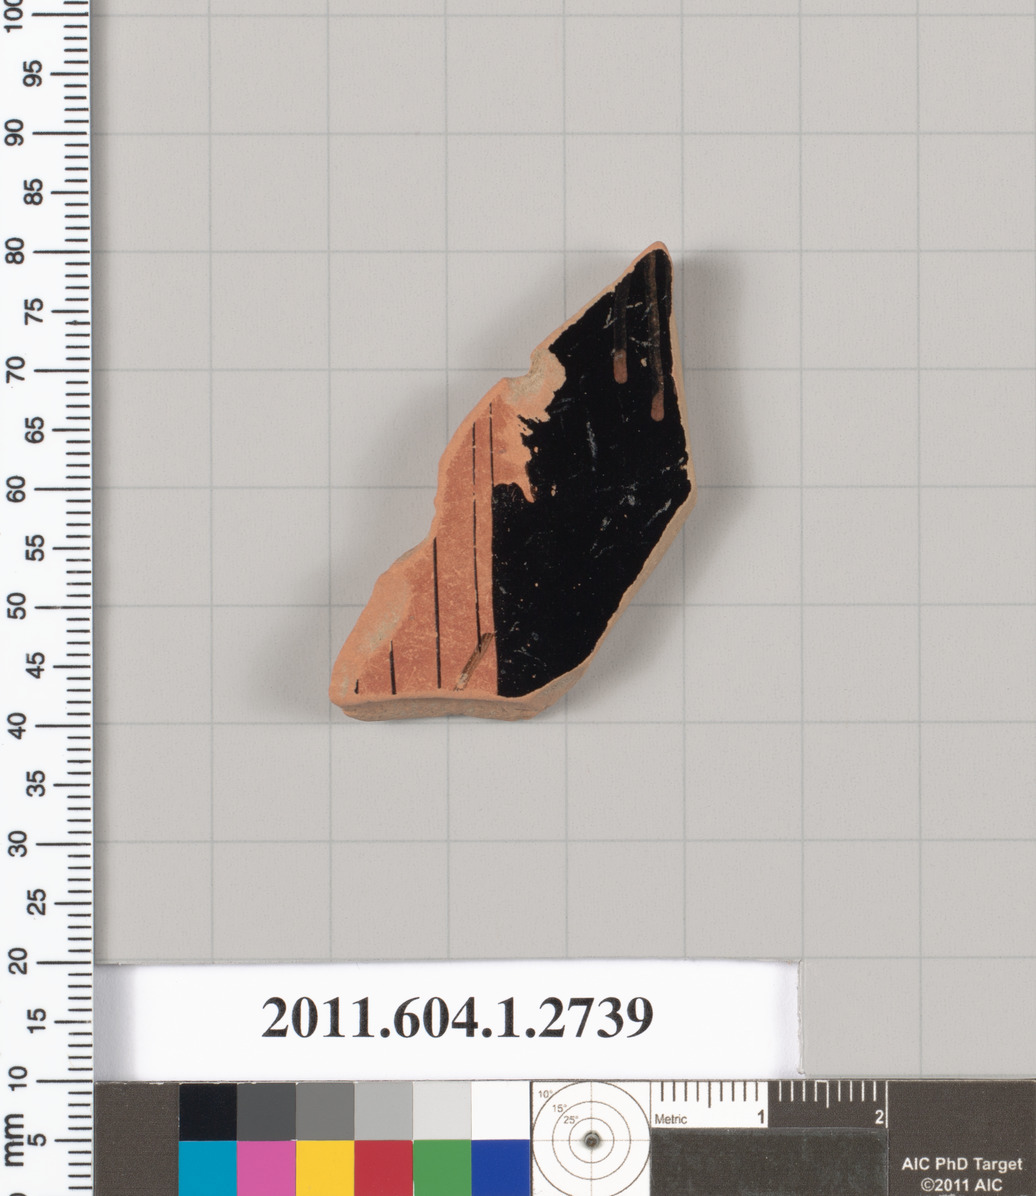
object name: kylix fragment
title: Terracotta fragment of a kylix (drinking cup)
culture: greek, attic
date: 475-451 BCE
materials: terracotta